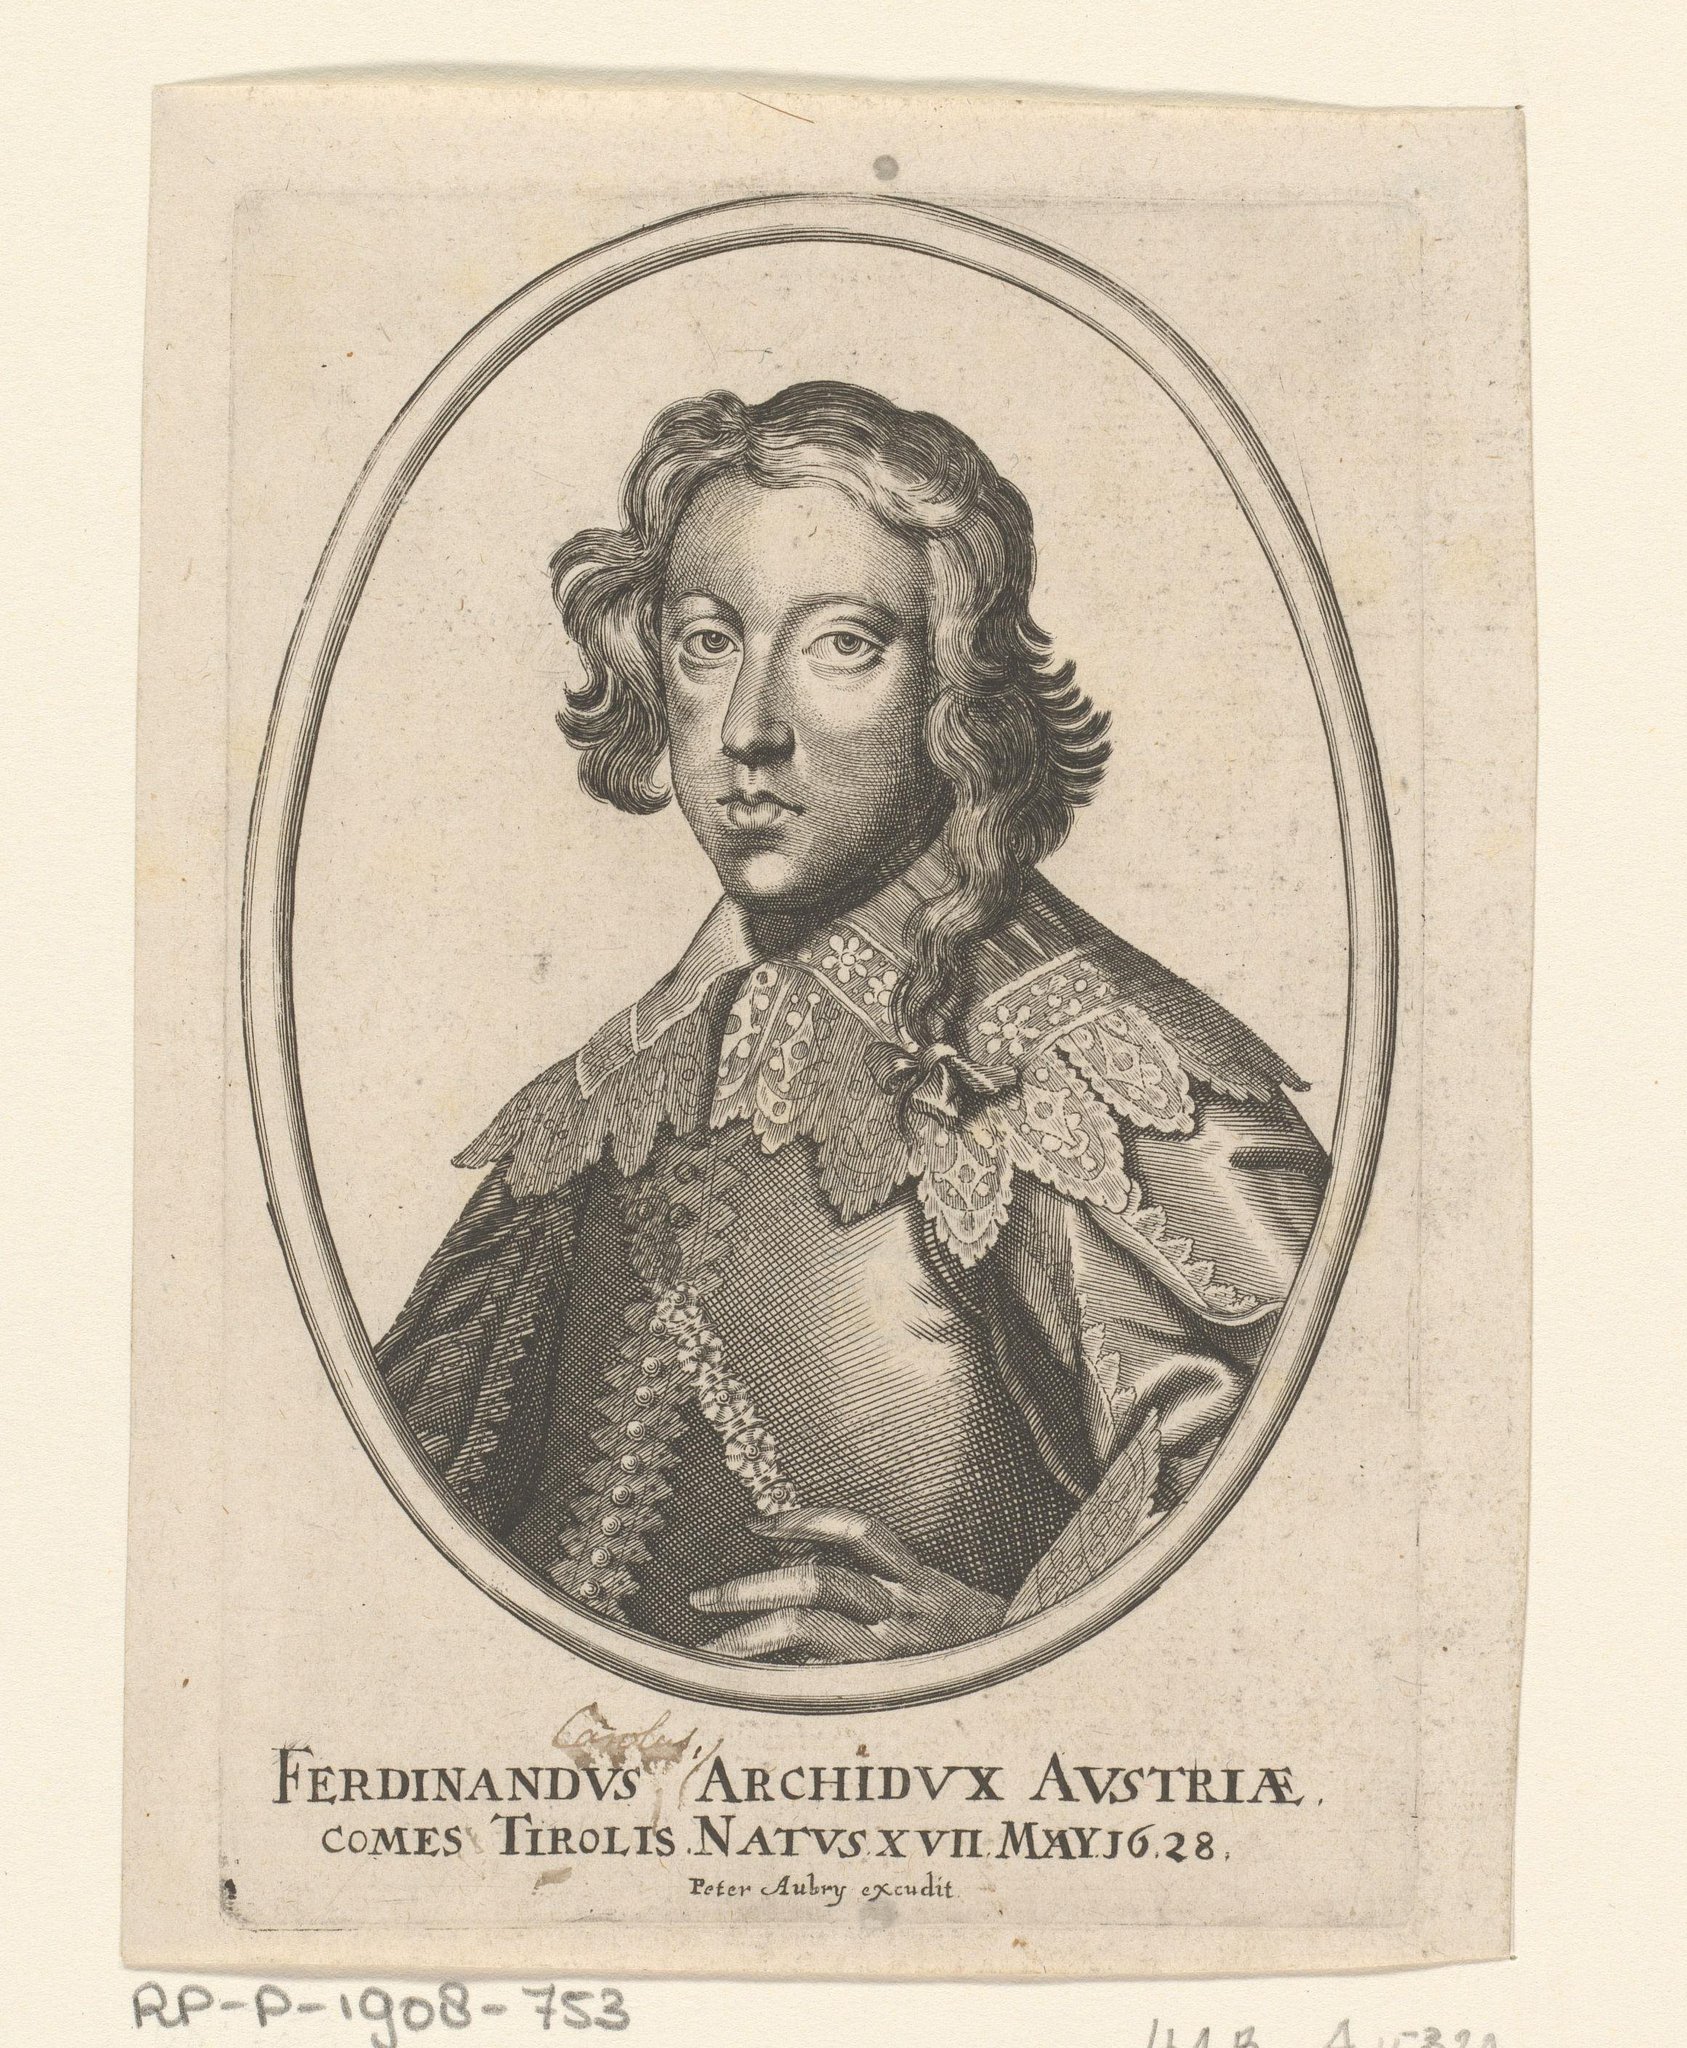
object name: print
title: Portret van Ferdinand Karl van Oostenrijk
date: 1651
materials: paper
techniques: engraving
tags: historical persons, ruler, sovereign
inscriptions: collector's mark: Lugt 2228, inscription: ‘Carolus’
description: Prent met boekdruk op recto en verso gebruikt in: Theatrum Europaeum (...). 1e druk. Frankfurt: erven Matthaus Merian, 1651, dl. 5. Mogelijk ook gebruikt in een latere druk van dit werk.